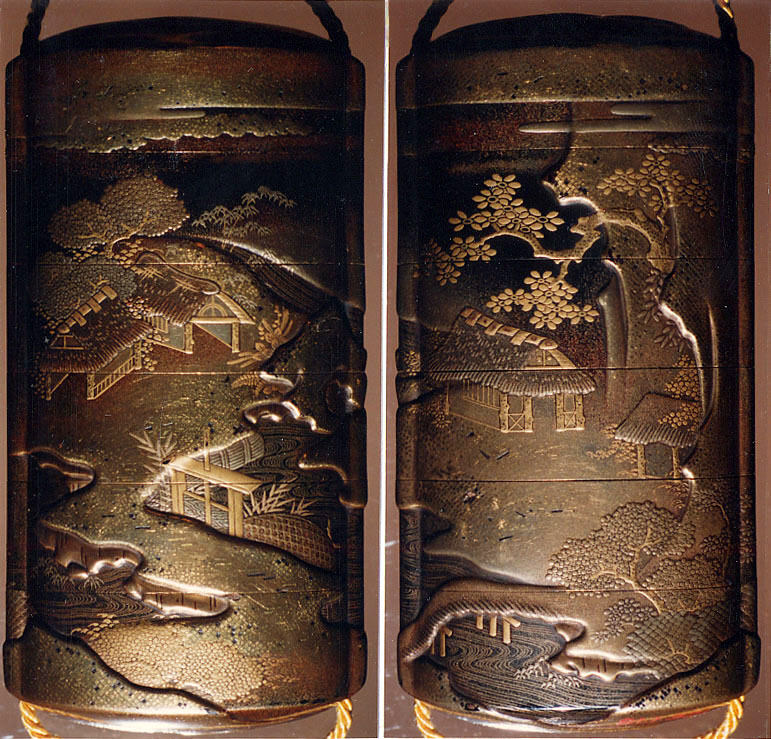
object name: inrō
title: Case (Inrō) with Design of Thatched Buildings Beside River Landscape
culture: japanese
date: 1701-1900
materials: gold, lacquer, silver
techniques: fundame, hiramakie, roiro, maki-e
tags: buildings,rivers,landscapes,trees